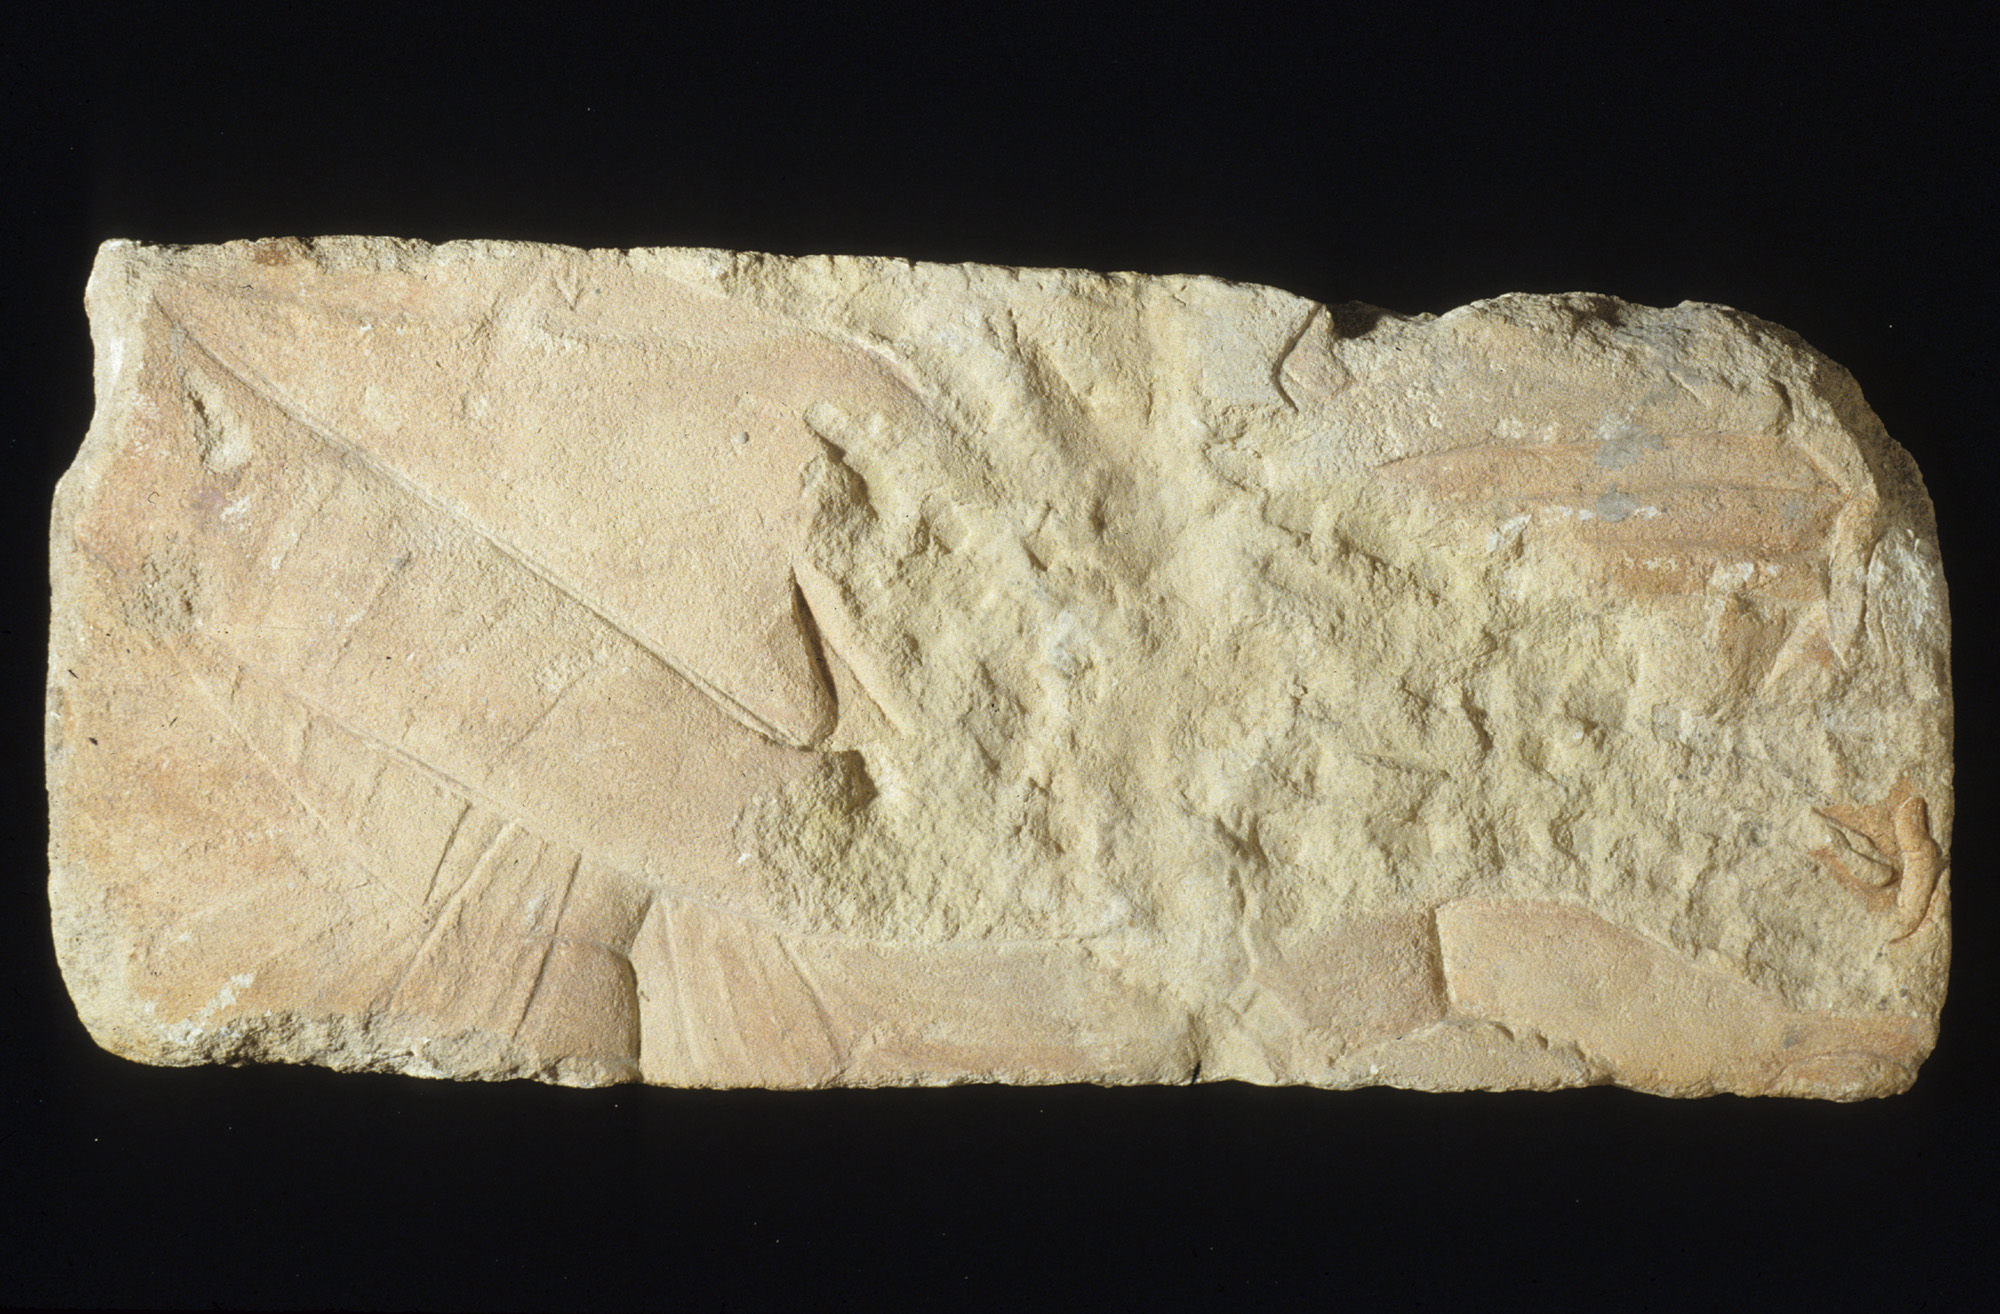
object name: talatat, queen's torso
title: Relief with the torso of the queen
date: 1353-1336 BCE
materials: limestone, paint